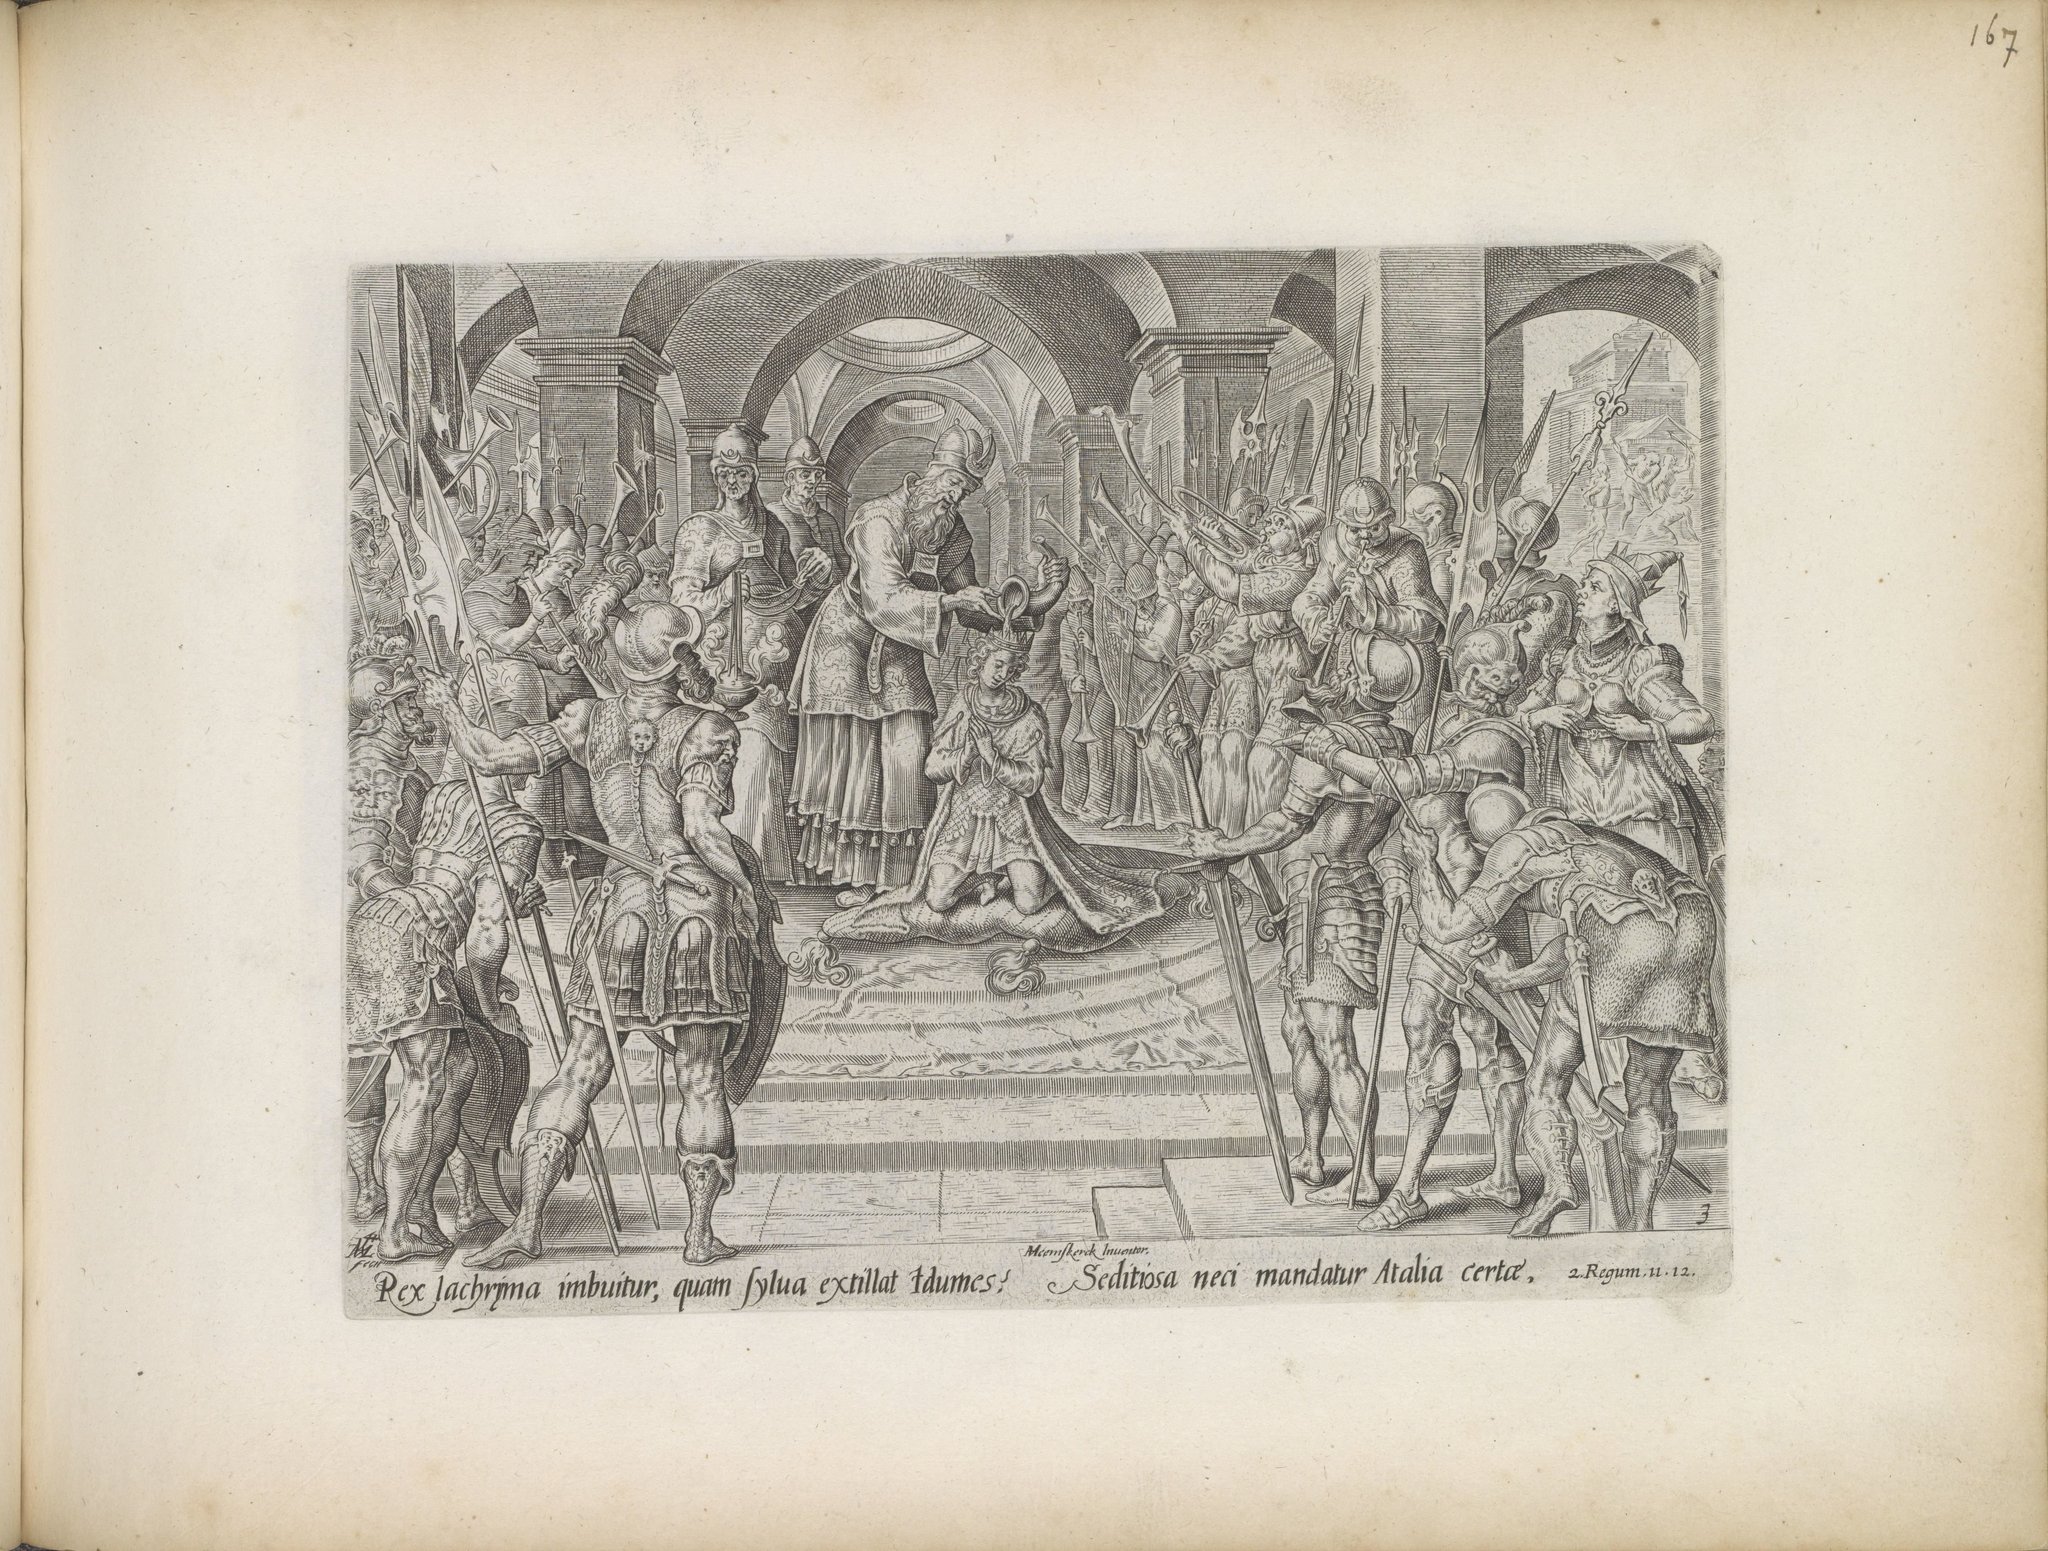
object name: print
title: Geschiedenis van Joas en koningin Atalja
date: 1565-1569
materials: paper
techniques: engraving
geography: amsterdam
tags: death of athalia: she is seized by soldiers, brought to the palace and killed at the horse gate, joash, protected by the soldiers, is crowned and anointed king; the people acclaim him, athalia hearing the noise of the people acclaiming king joash, comes to the temple and sees the new king standing by a pillar; she tears her clothes in dismay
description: De hogepriester Jojada giet zalfolie over het hoofd van Joas en roept hem uit tot koning. Omstanders blazen op trompetten en bespelen de harp. Tussen de soldaten rechts kijkt koningin Atalja toe, terwijl ze haar kleren scheurt. Rechts in de achtergrond wordt koningin Atalja gedood. Onderaan in de marge een vers in het Latijn en een verwijzing naar de Bijbeltekst in 2 Kon. 11:12. Deze prent maakt deel uit van een album.